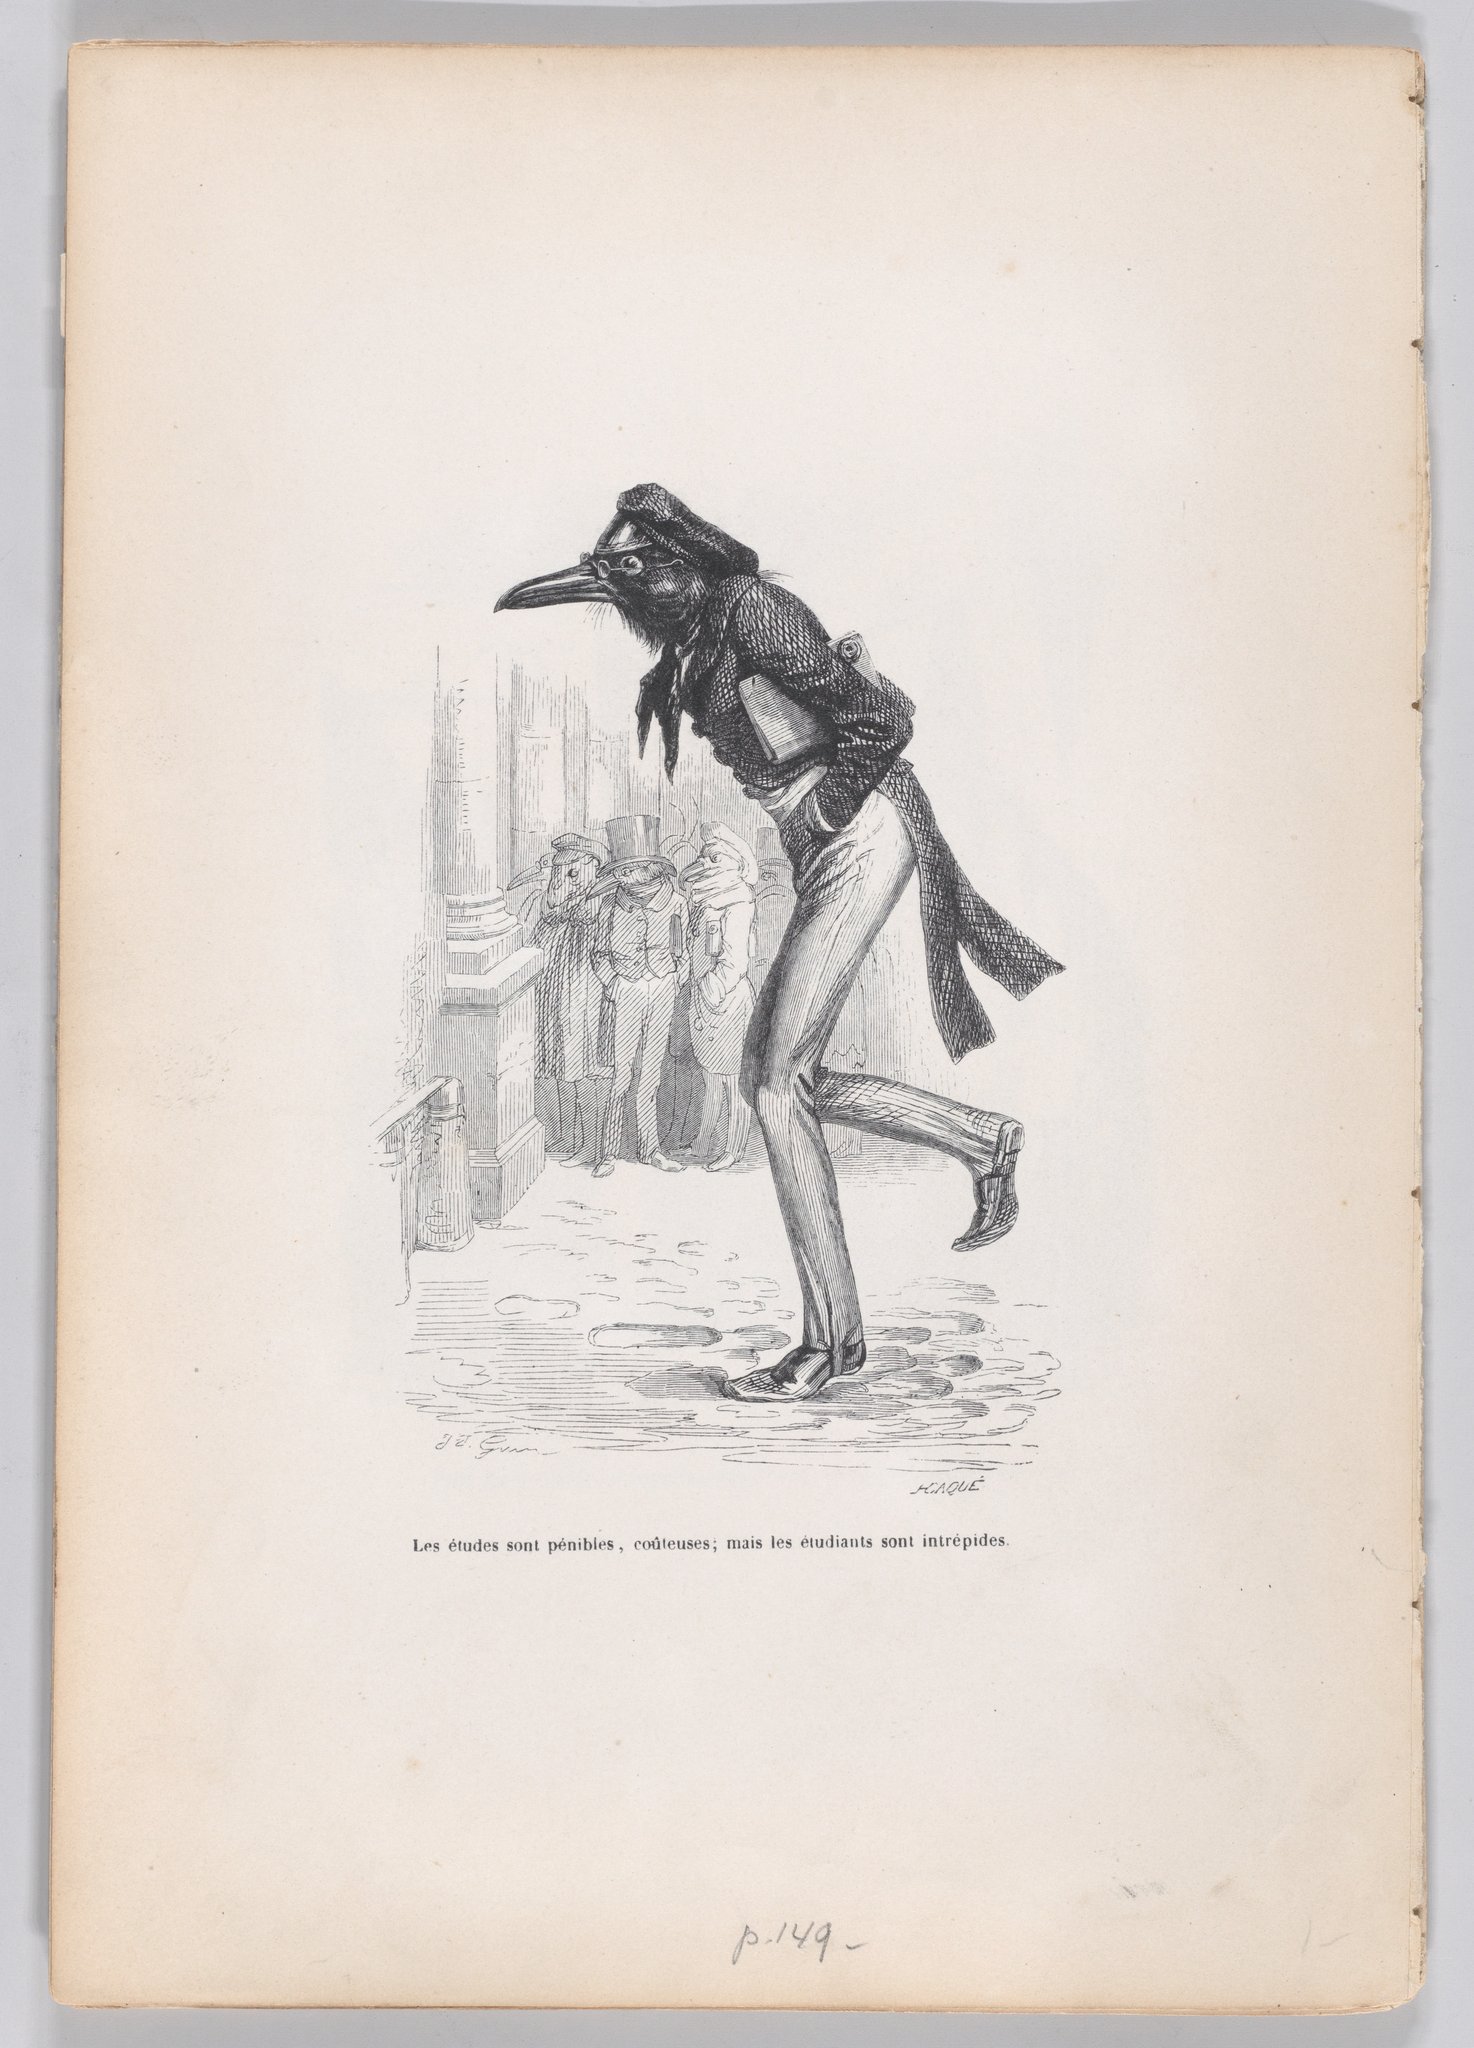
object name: print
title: The studies are painful, expensive; but the students are intrepid, from "Scenes from the Private and Public Life of Animals"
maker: j. j. grandville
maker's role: illustrator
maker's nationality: french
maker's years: 1803-1847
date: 1837-1847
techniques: engraving